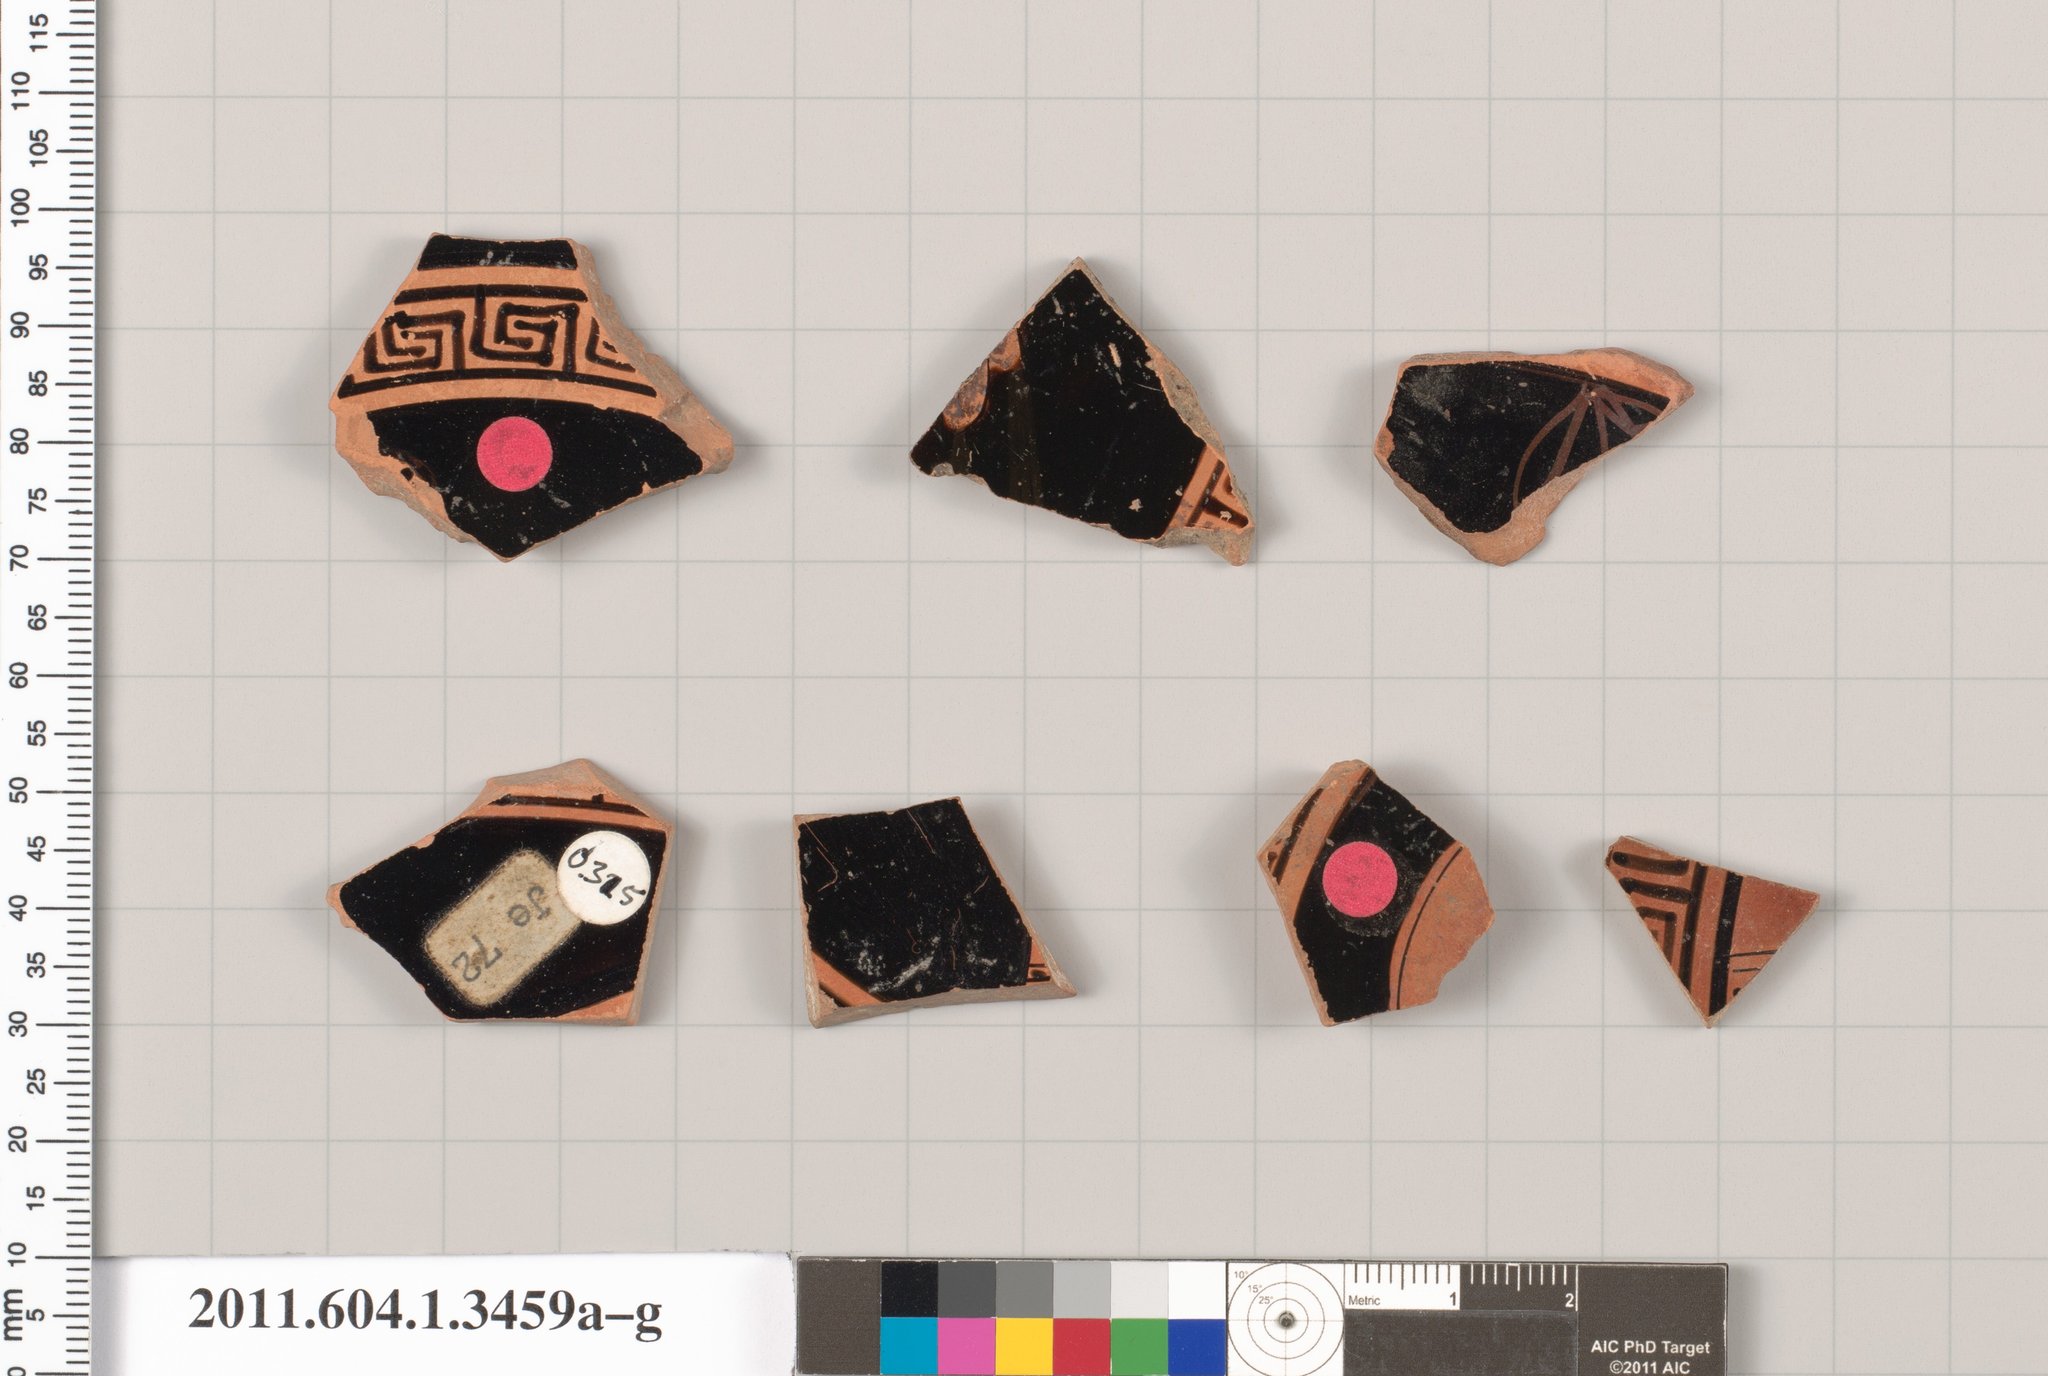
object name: kylix fragment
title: Terracotta fragments of kylikes (drinking cups)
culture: greek, attic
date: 500-470 BCE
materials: terracotta